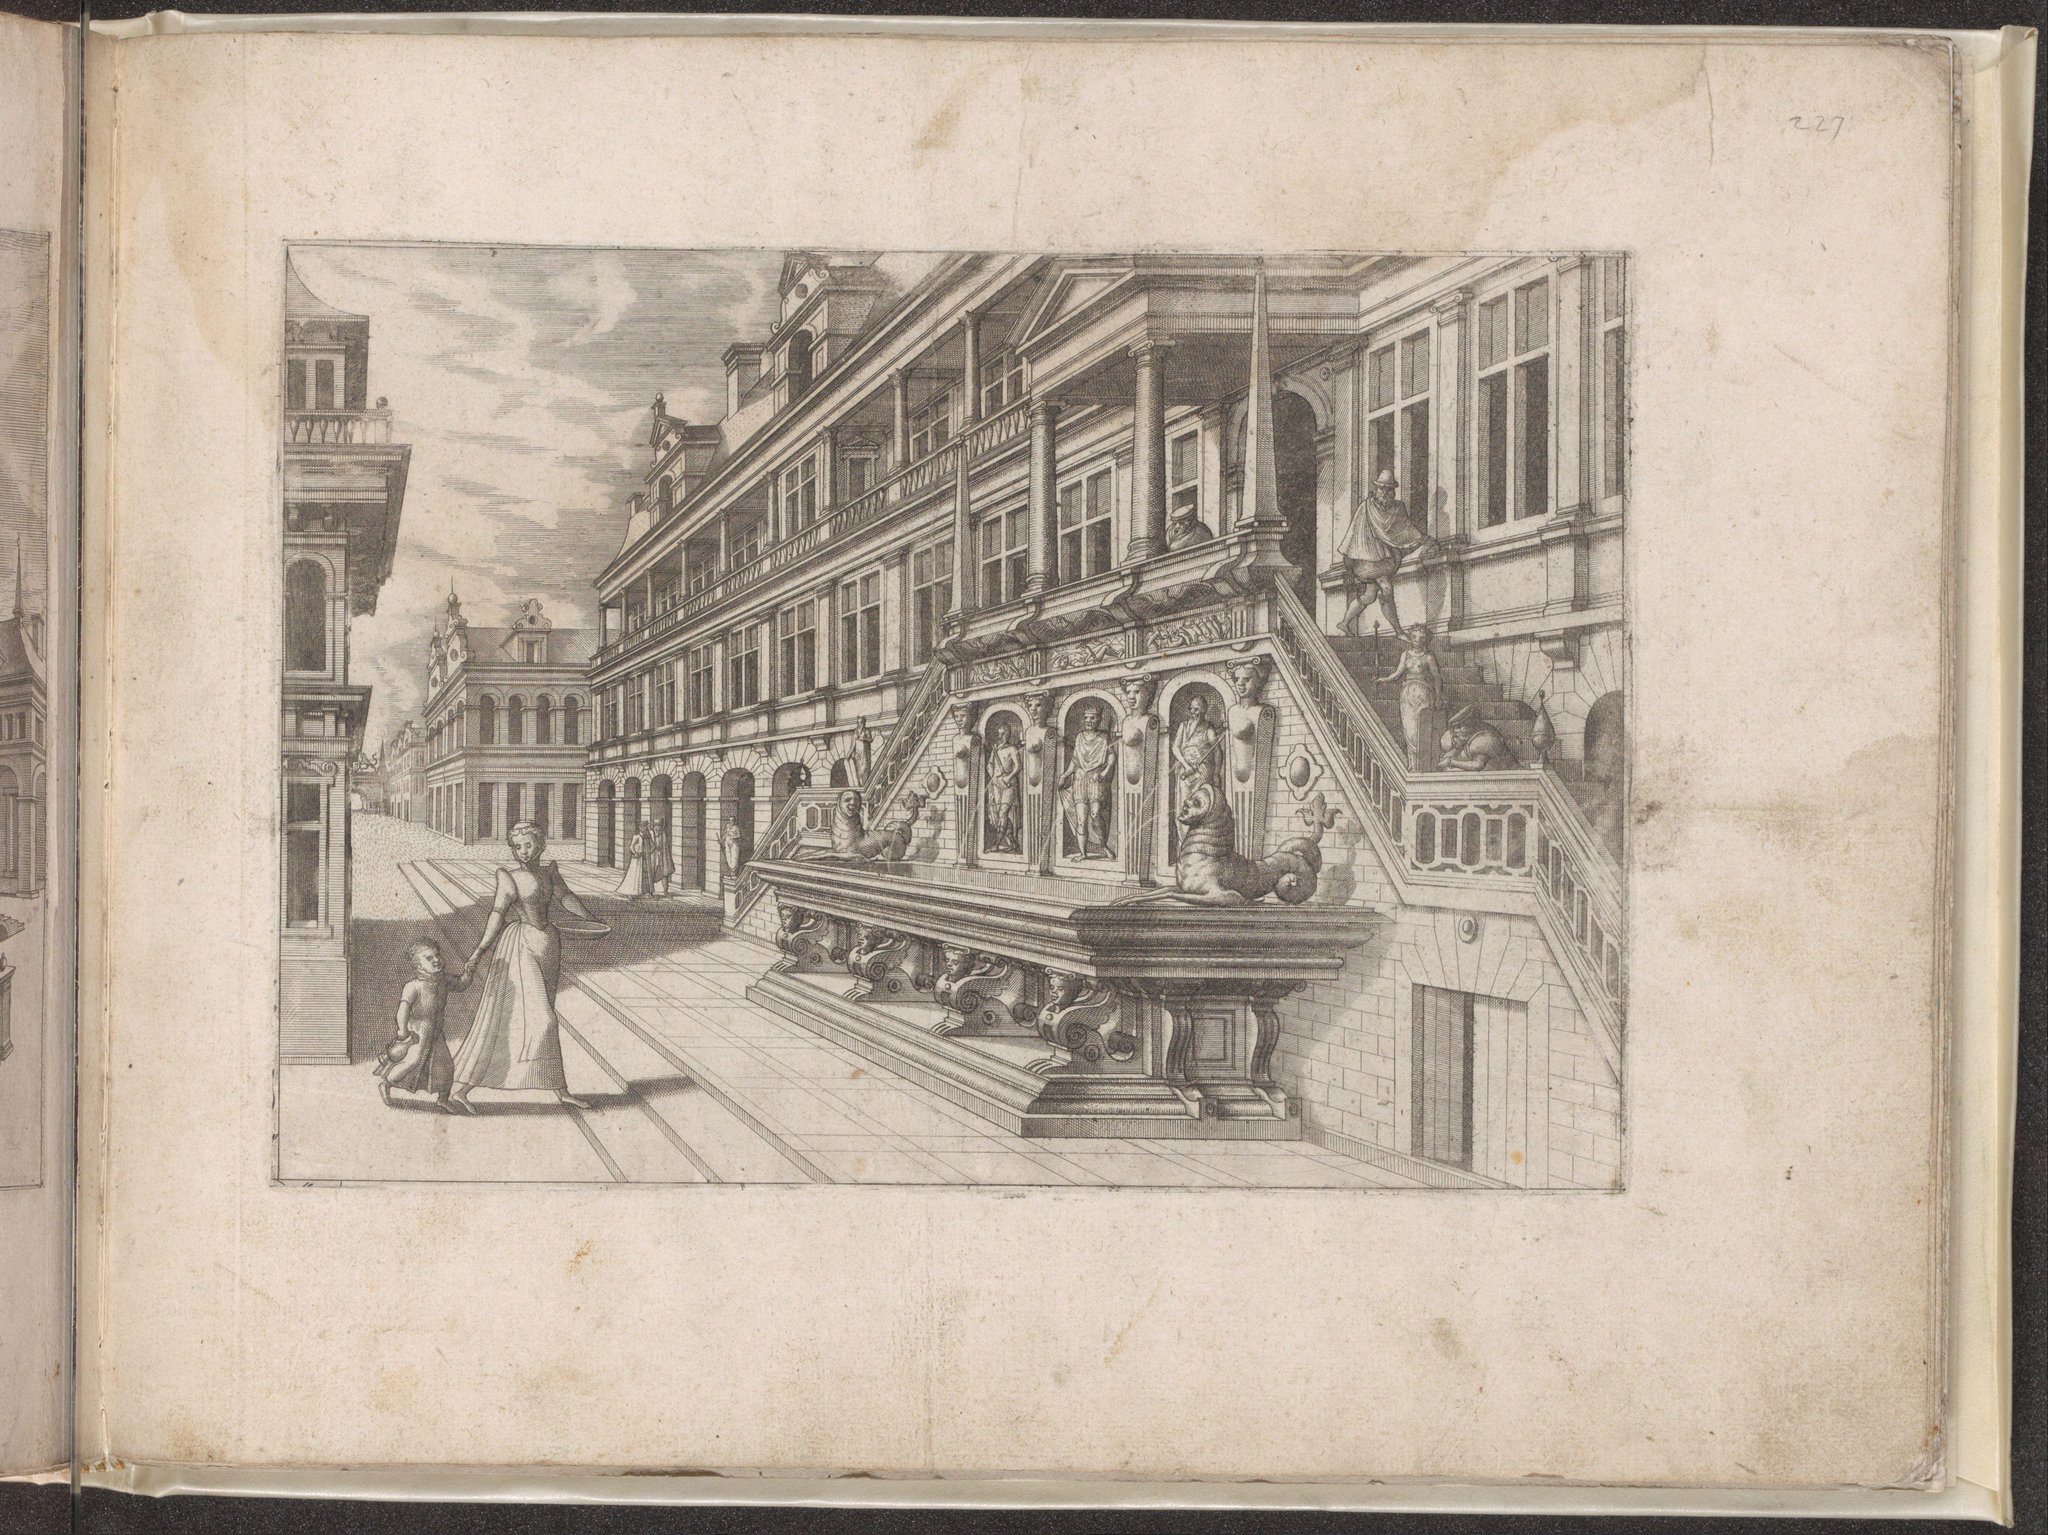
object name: album leaf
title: Artis Perspectivae (...)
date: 1568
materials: paper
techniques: etching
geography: antwerp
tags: piece of sculpture, reproduction of a piece of sculpture, ornamental fountain, civic architecture; edifices; dwellings, street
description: Straatgezicht met rechts een muurfontein met drie standbeelden in nissen. De fontein is geplaats tegen de zijkant van een trap. Links op straat een vrouw met een kind aan de hand. Deze prent maakt deel uit van een album.